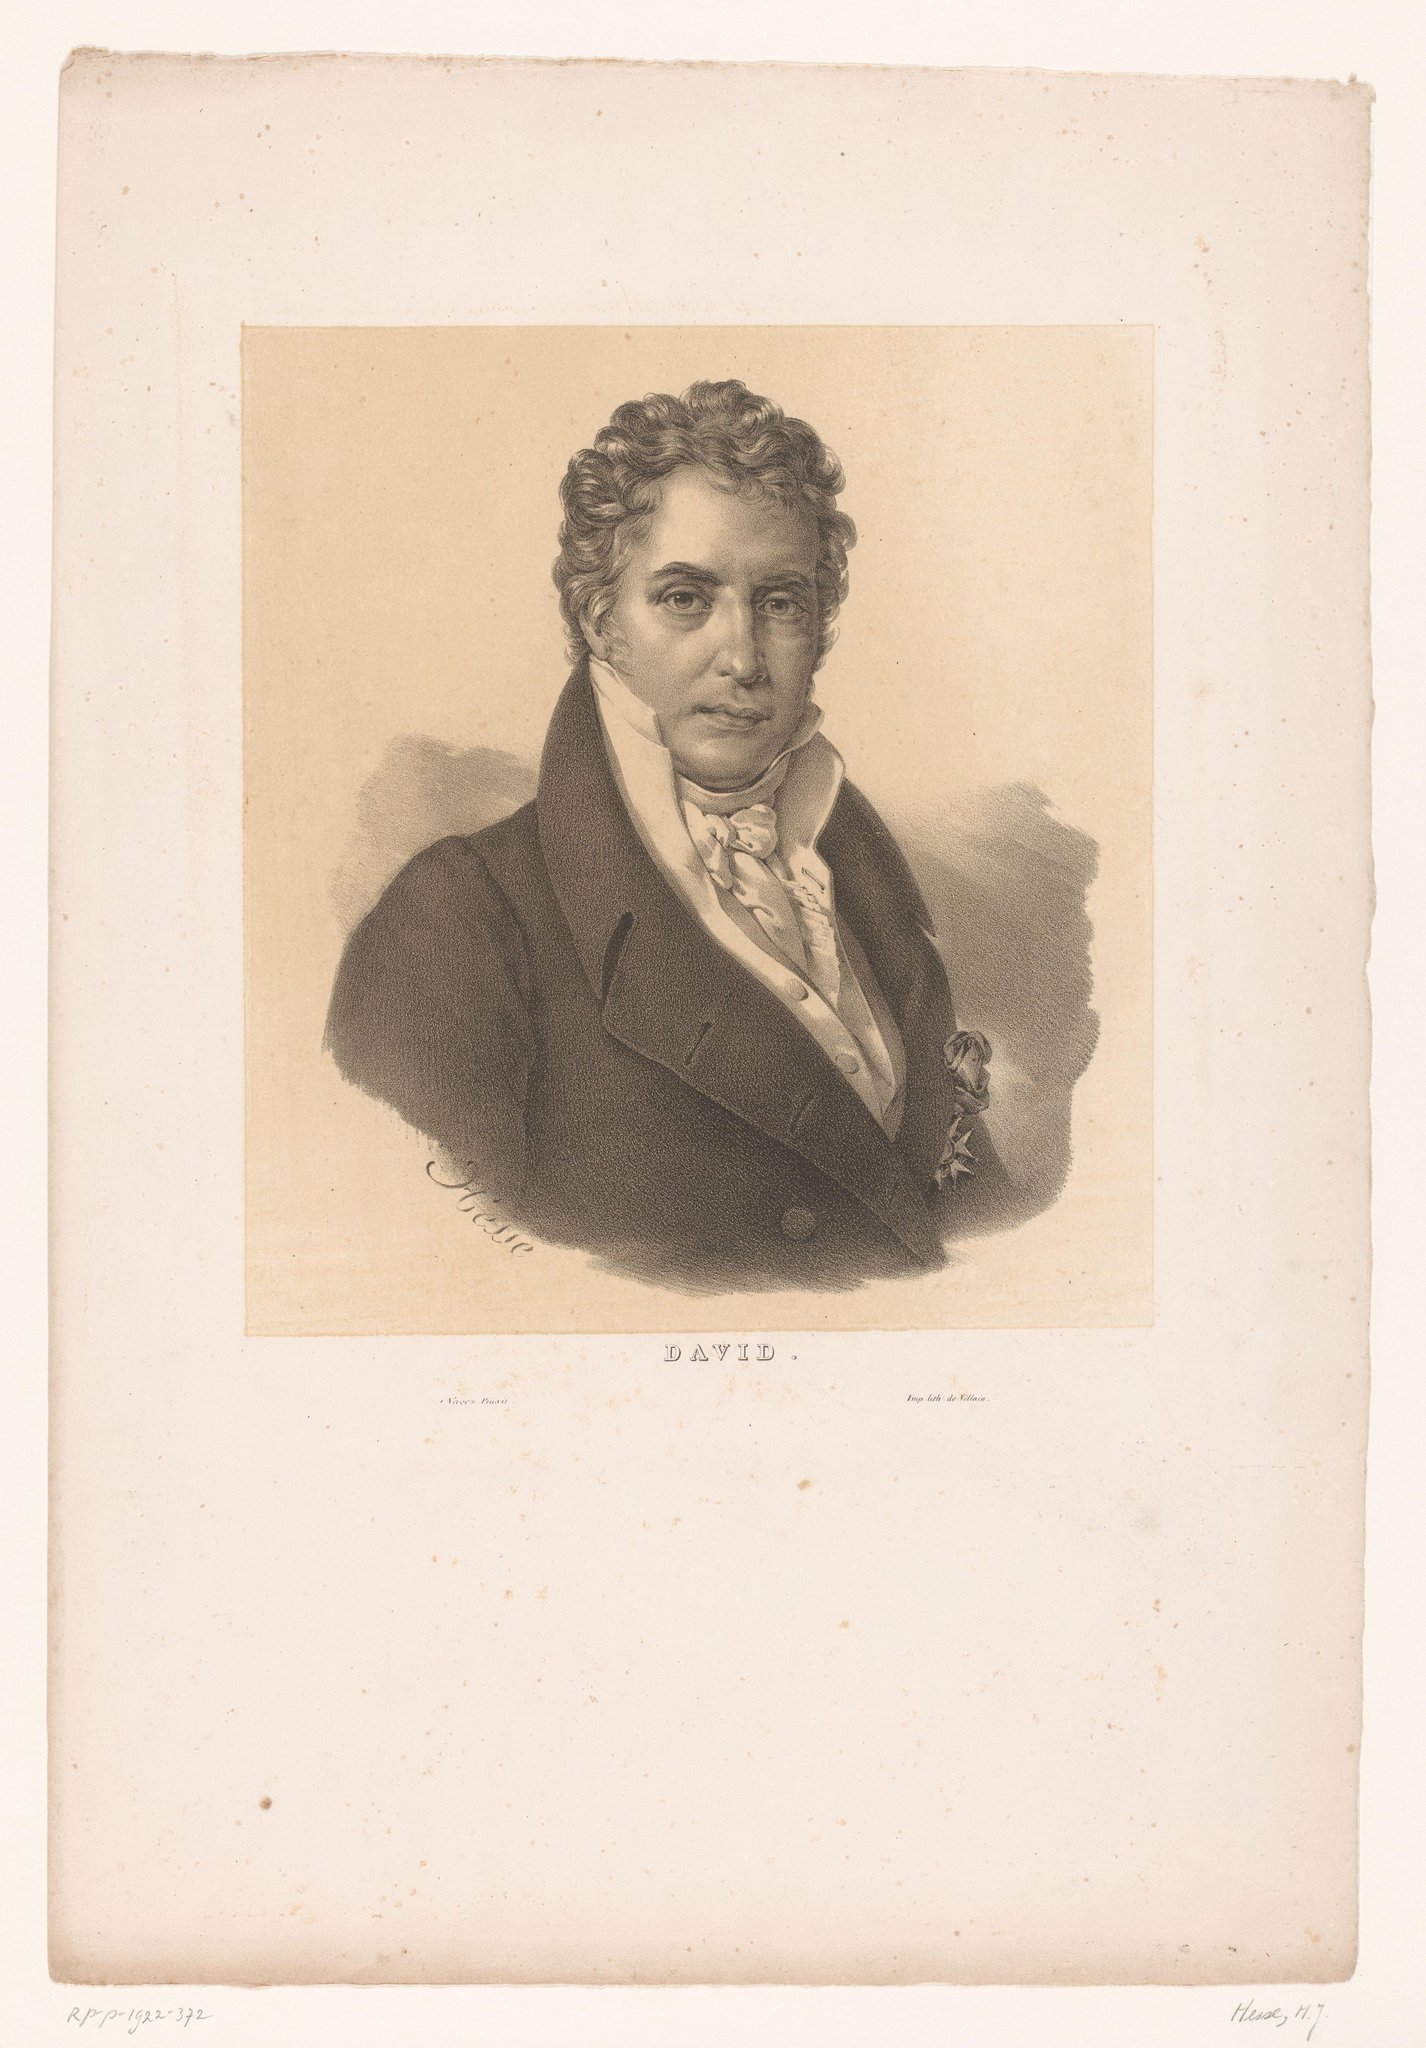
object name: print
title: David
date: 1822-1832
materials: paper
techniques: lithograph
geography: paris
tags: paris, brussels, painter, draughtsman, jacques-louis david, historical persons, portrait, self-portrait of painter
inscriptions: check stamp: ‘JC (?)’, collector's mark: Lugt 2233